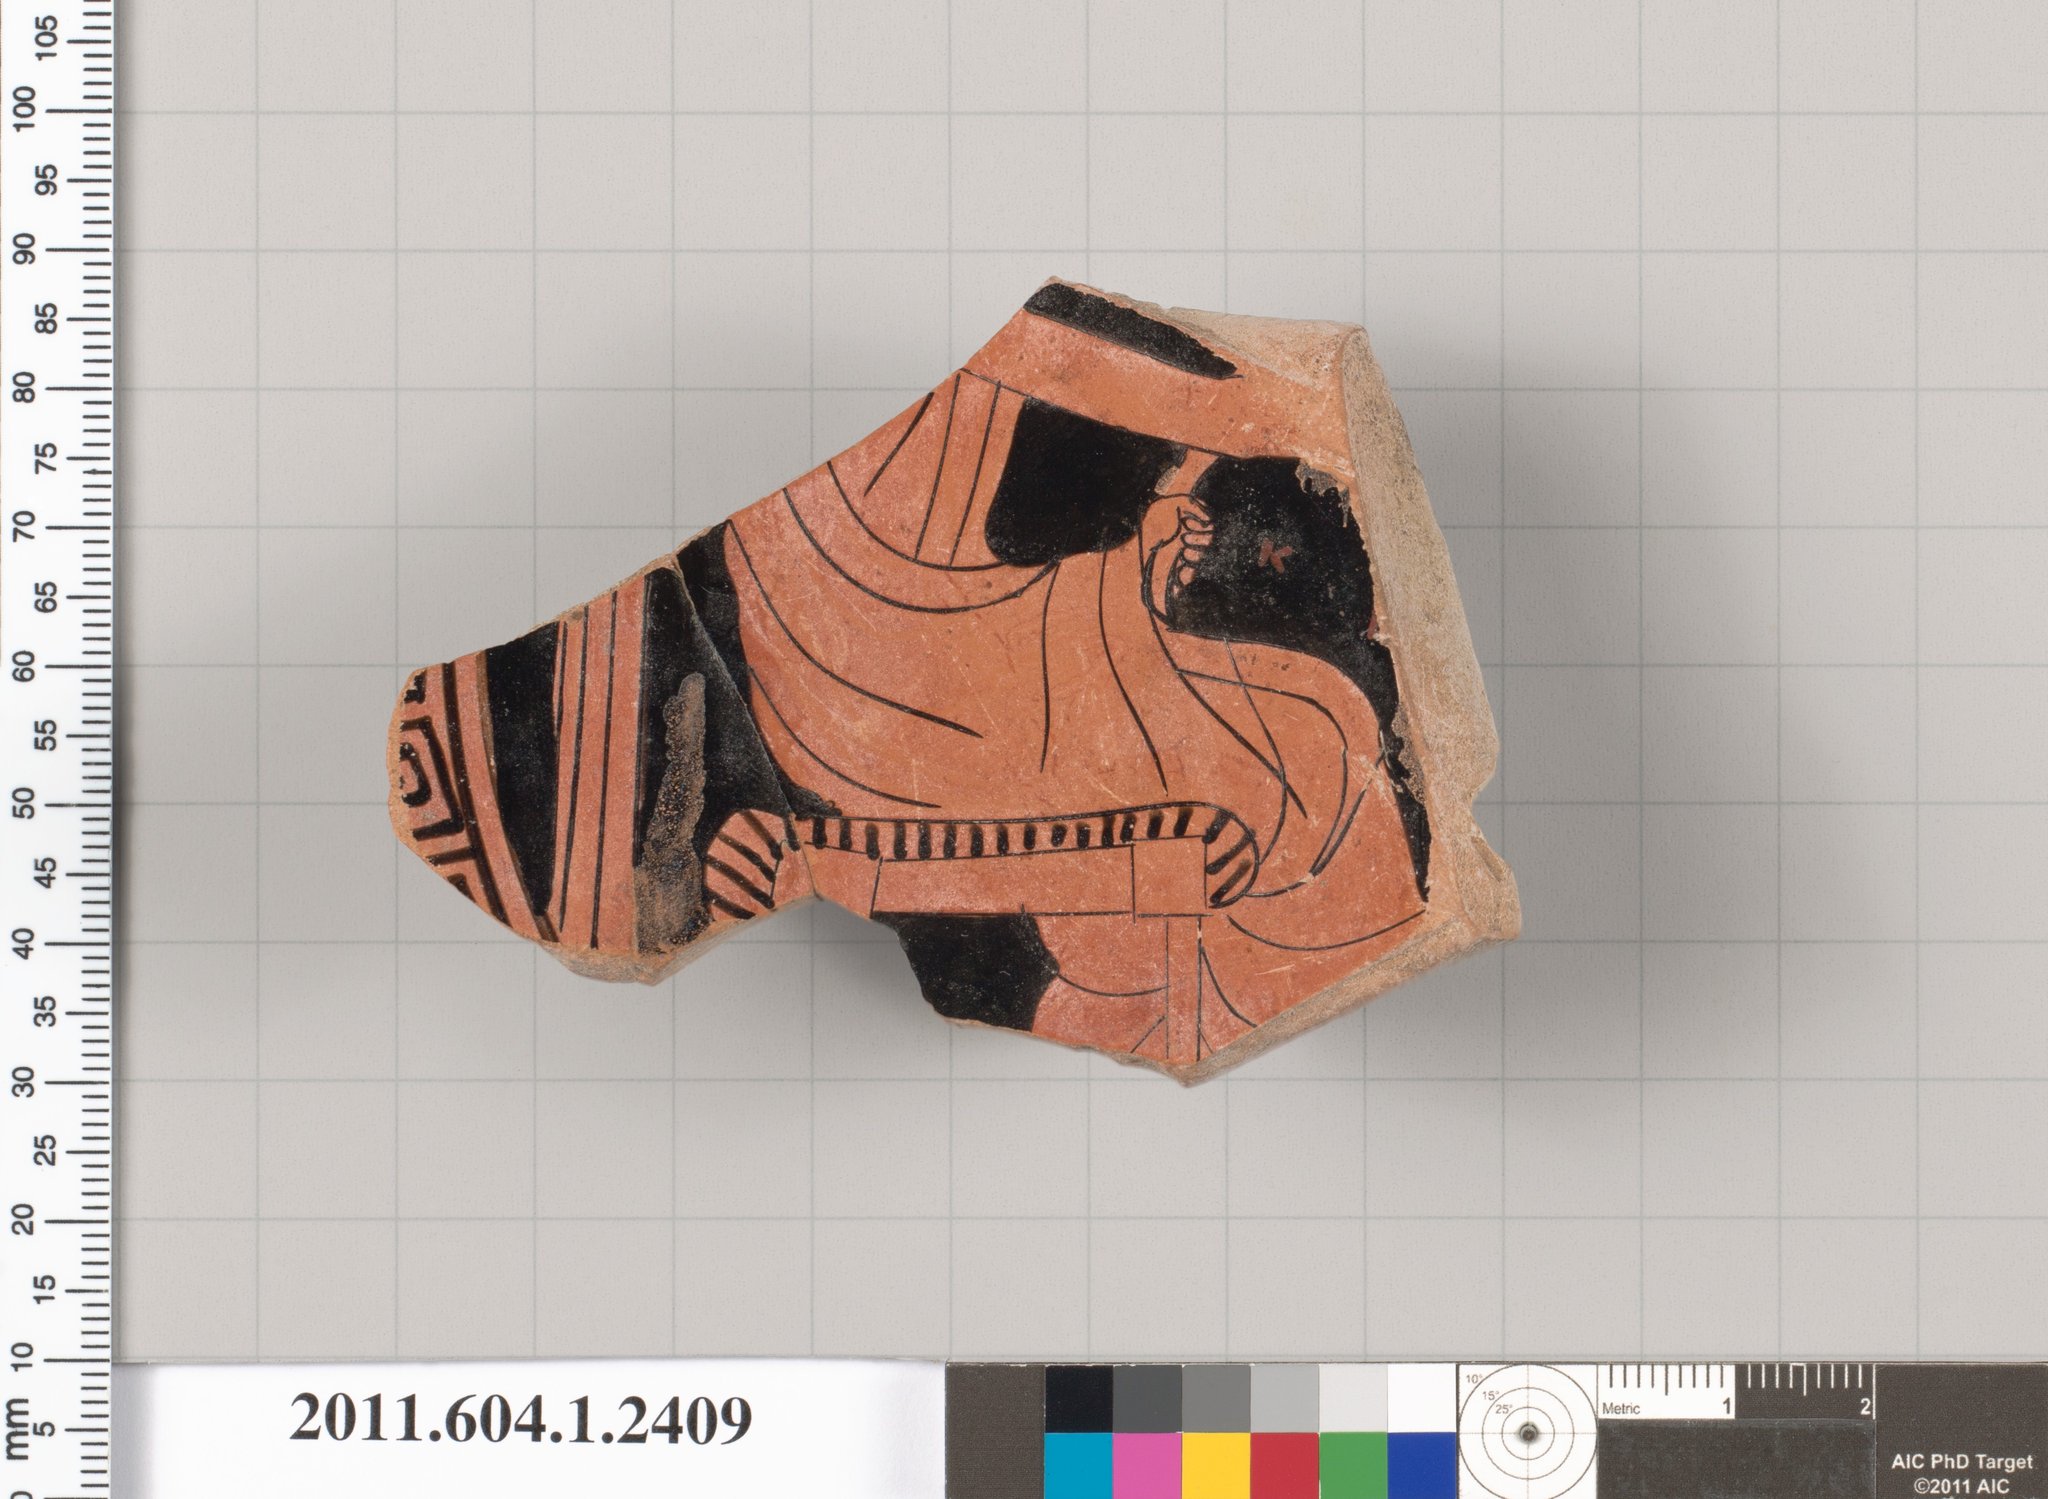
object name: kylix fragment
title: Terracotta fragment of a kylix (drinking cup)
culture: greek, attic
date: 475-451 BCE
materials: terracotta